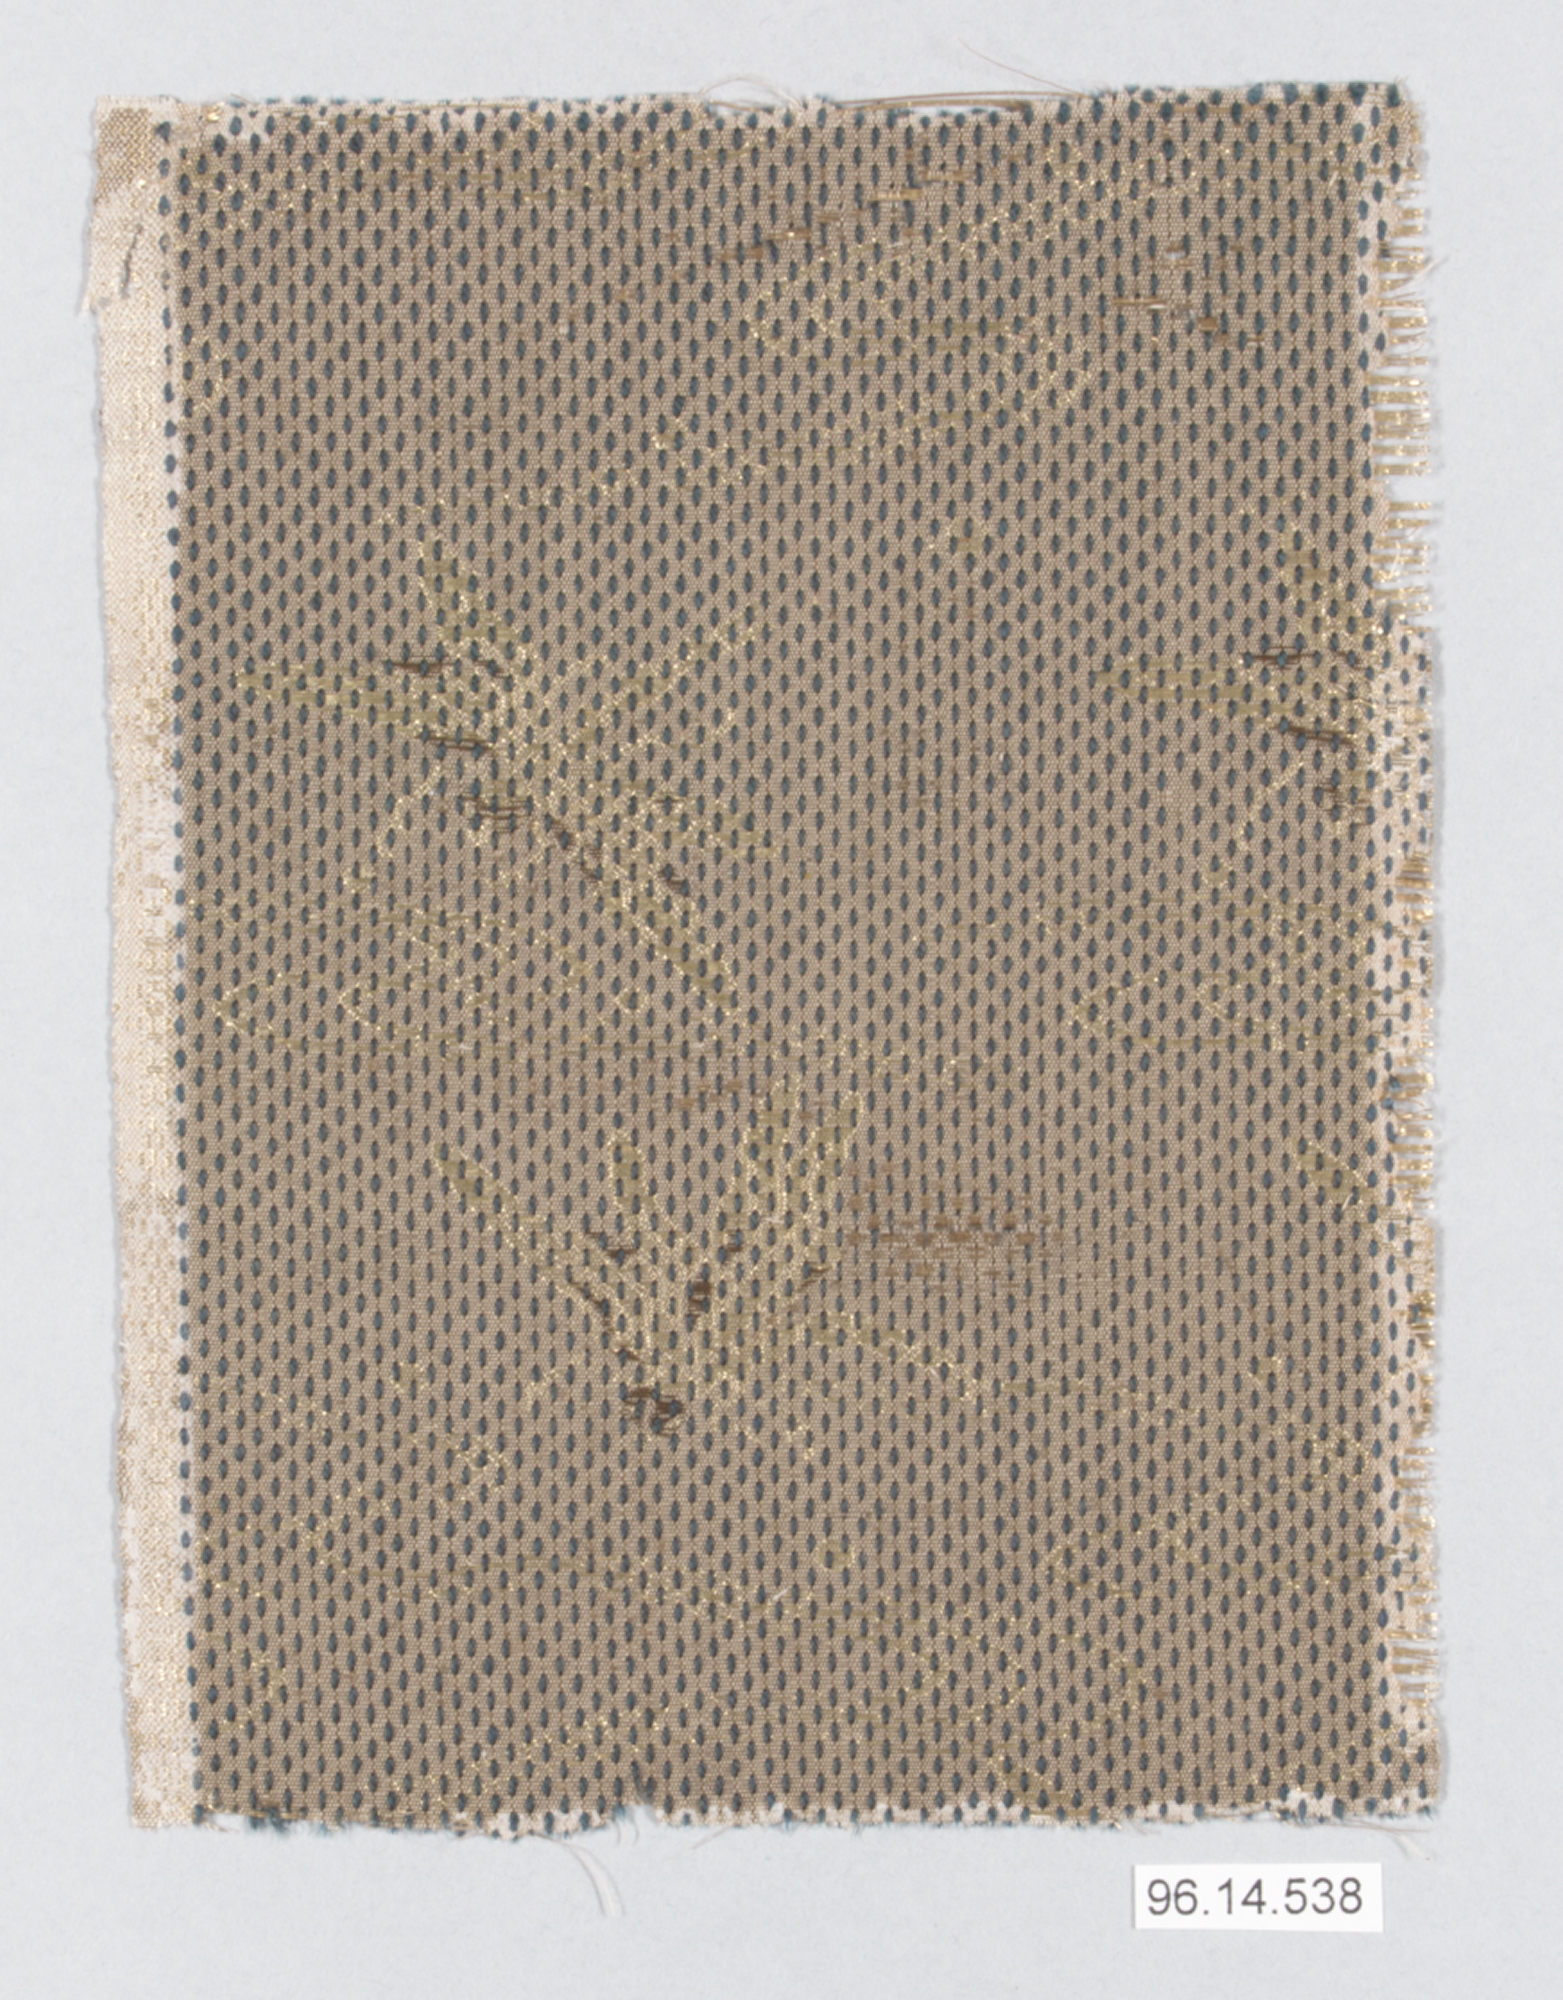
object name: piece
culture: japanese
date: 1801-1900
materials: metal thread, silk